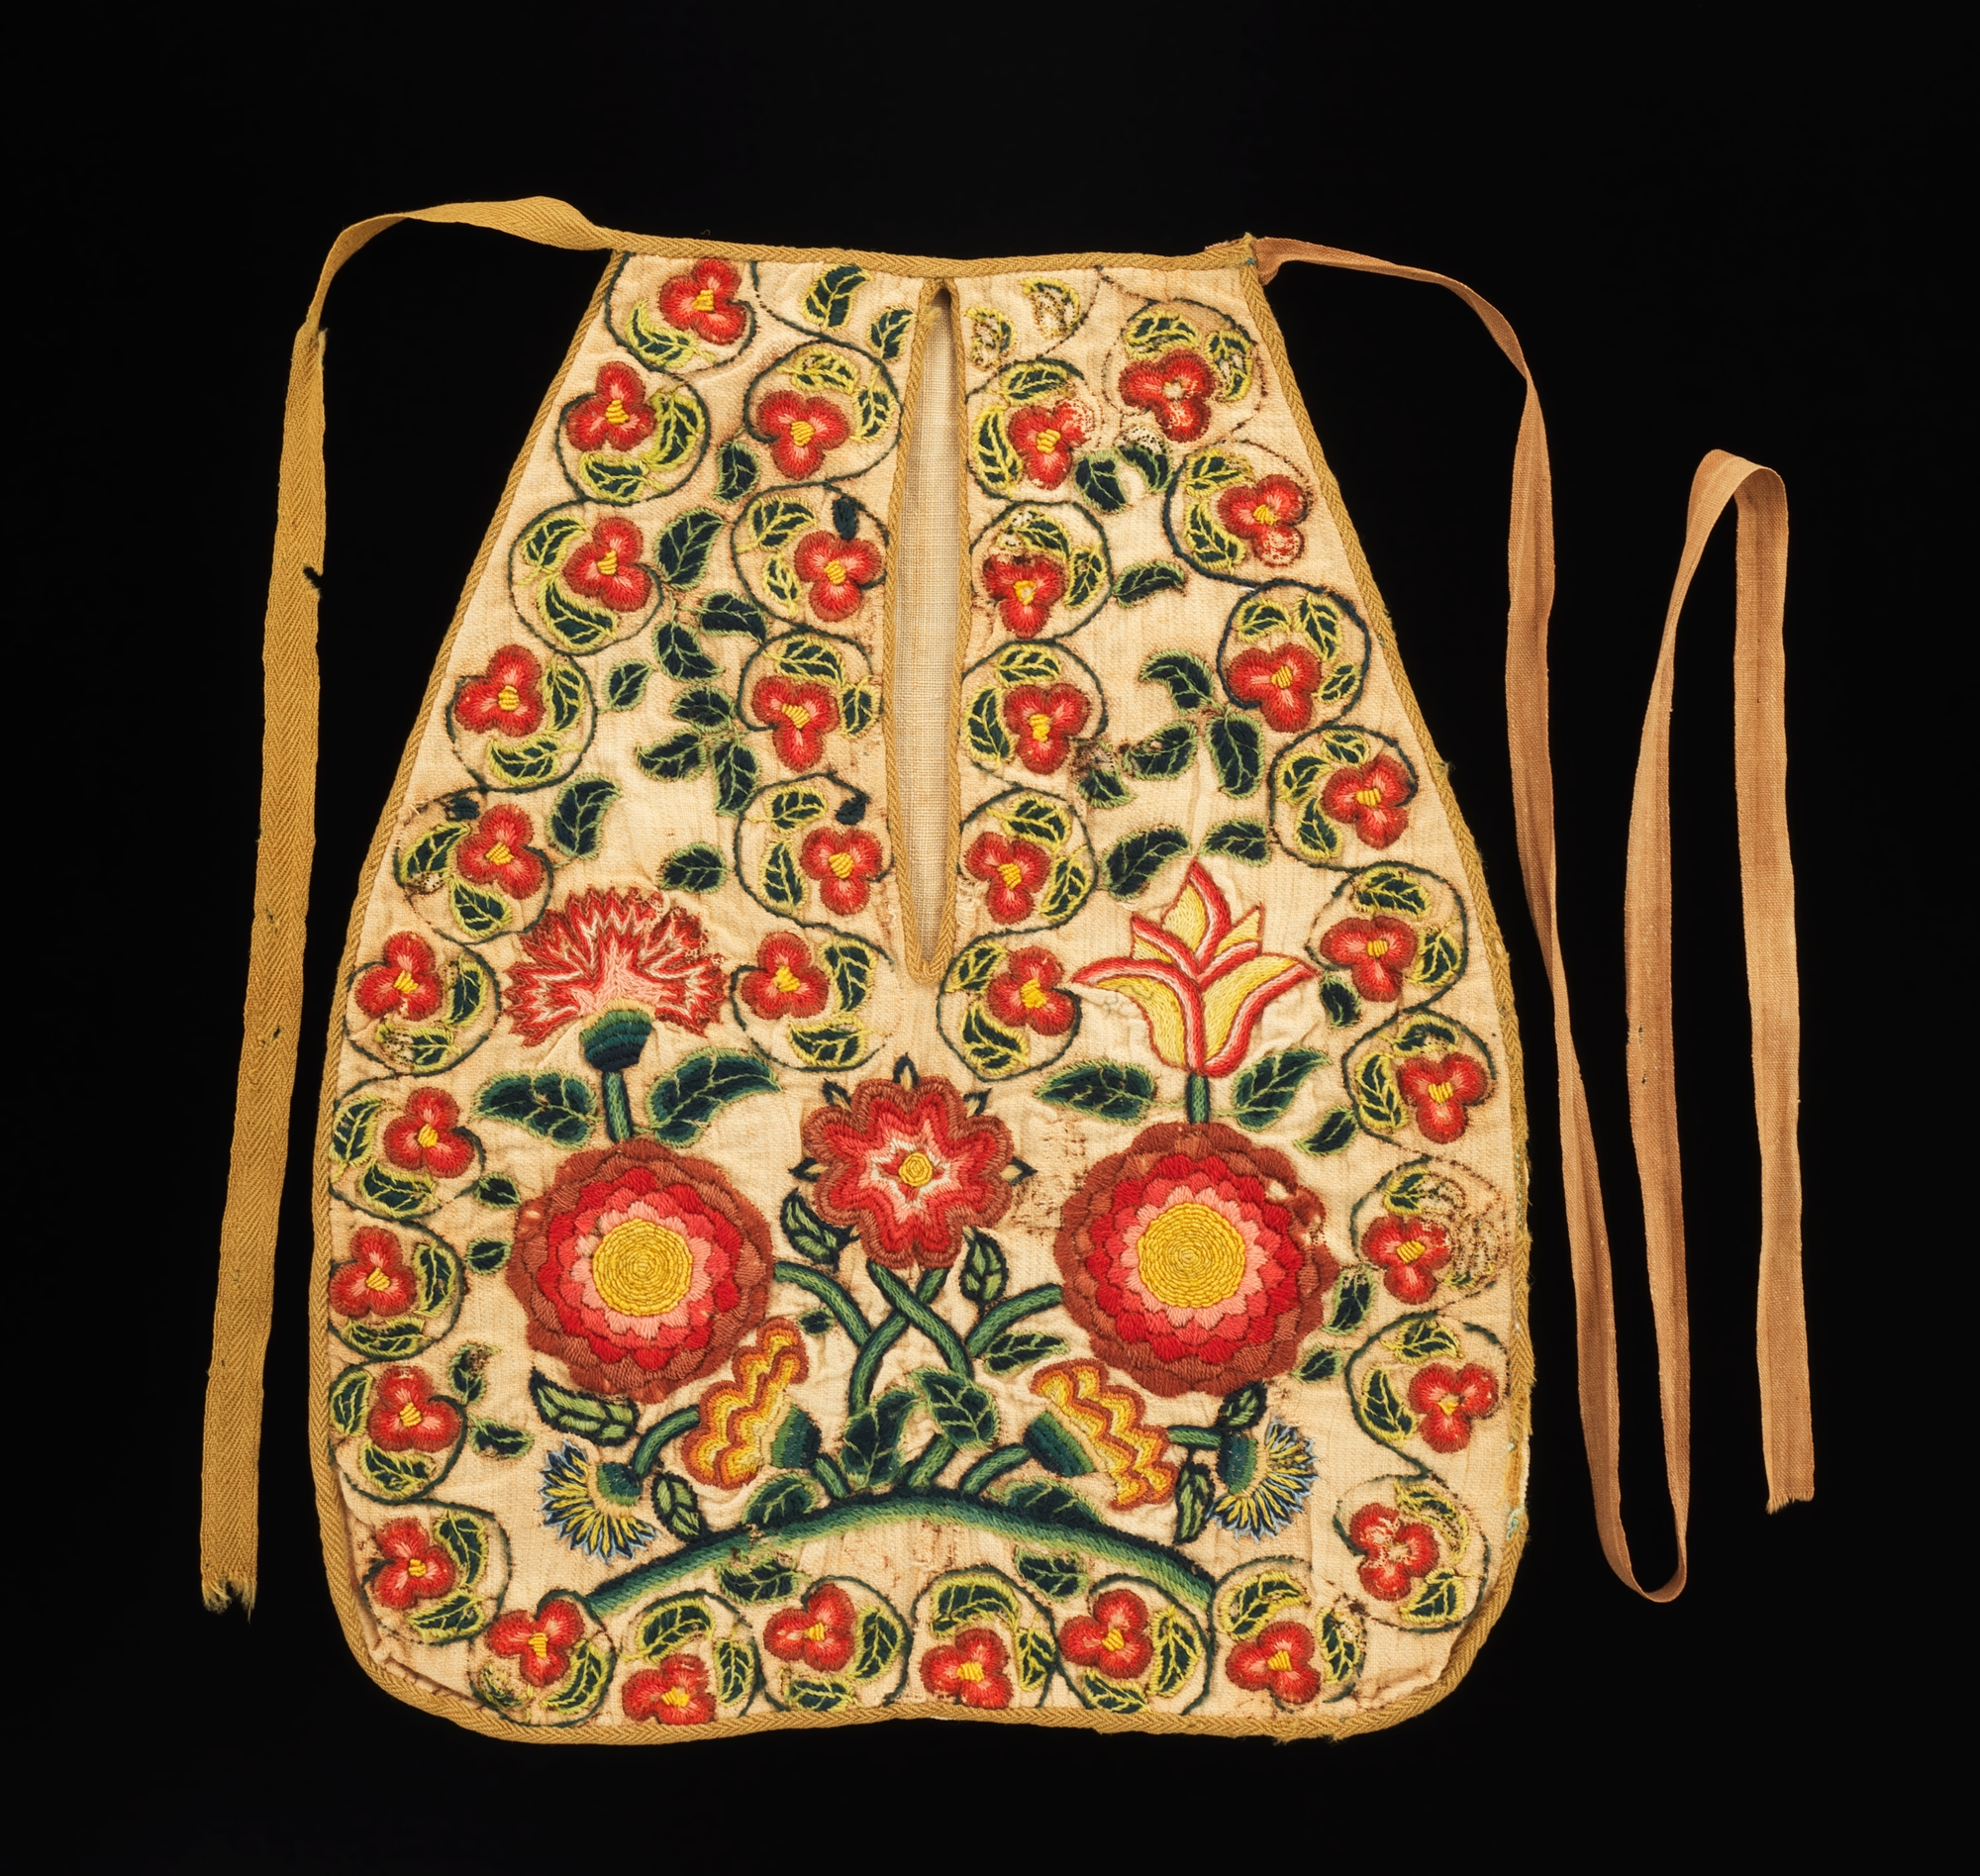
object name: pocket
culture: american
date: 1784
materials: cotton, wool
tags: roses